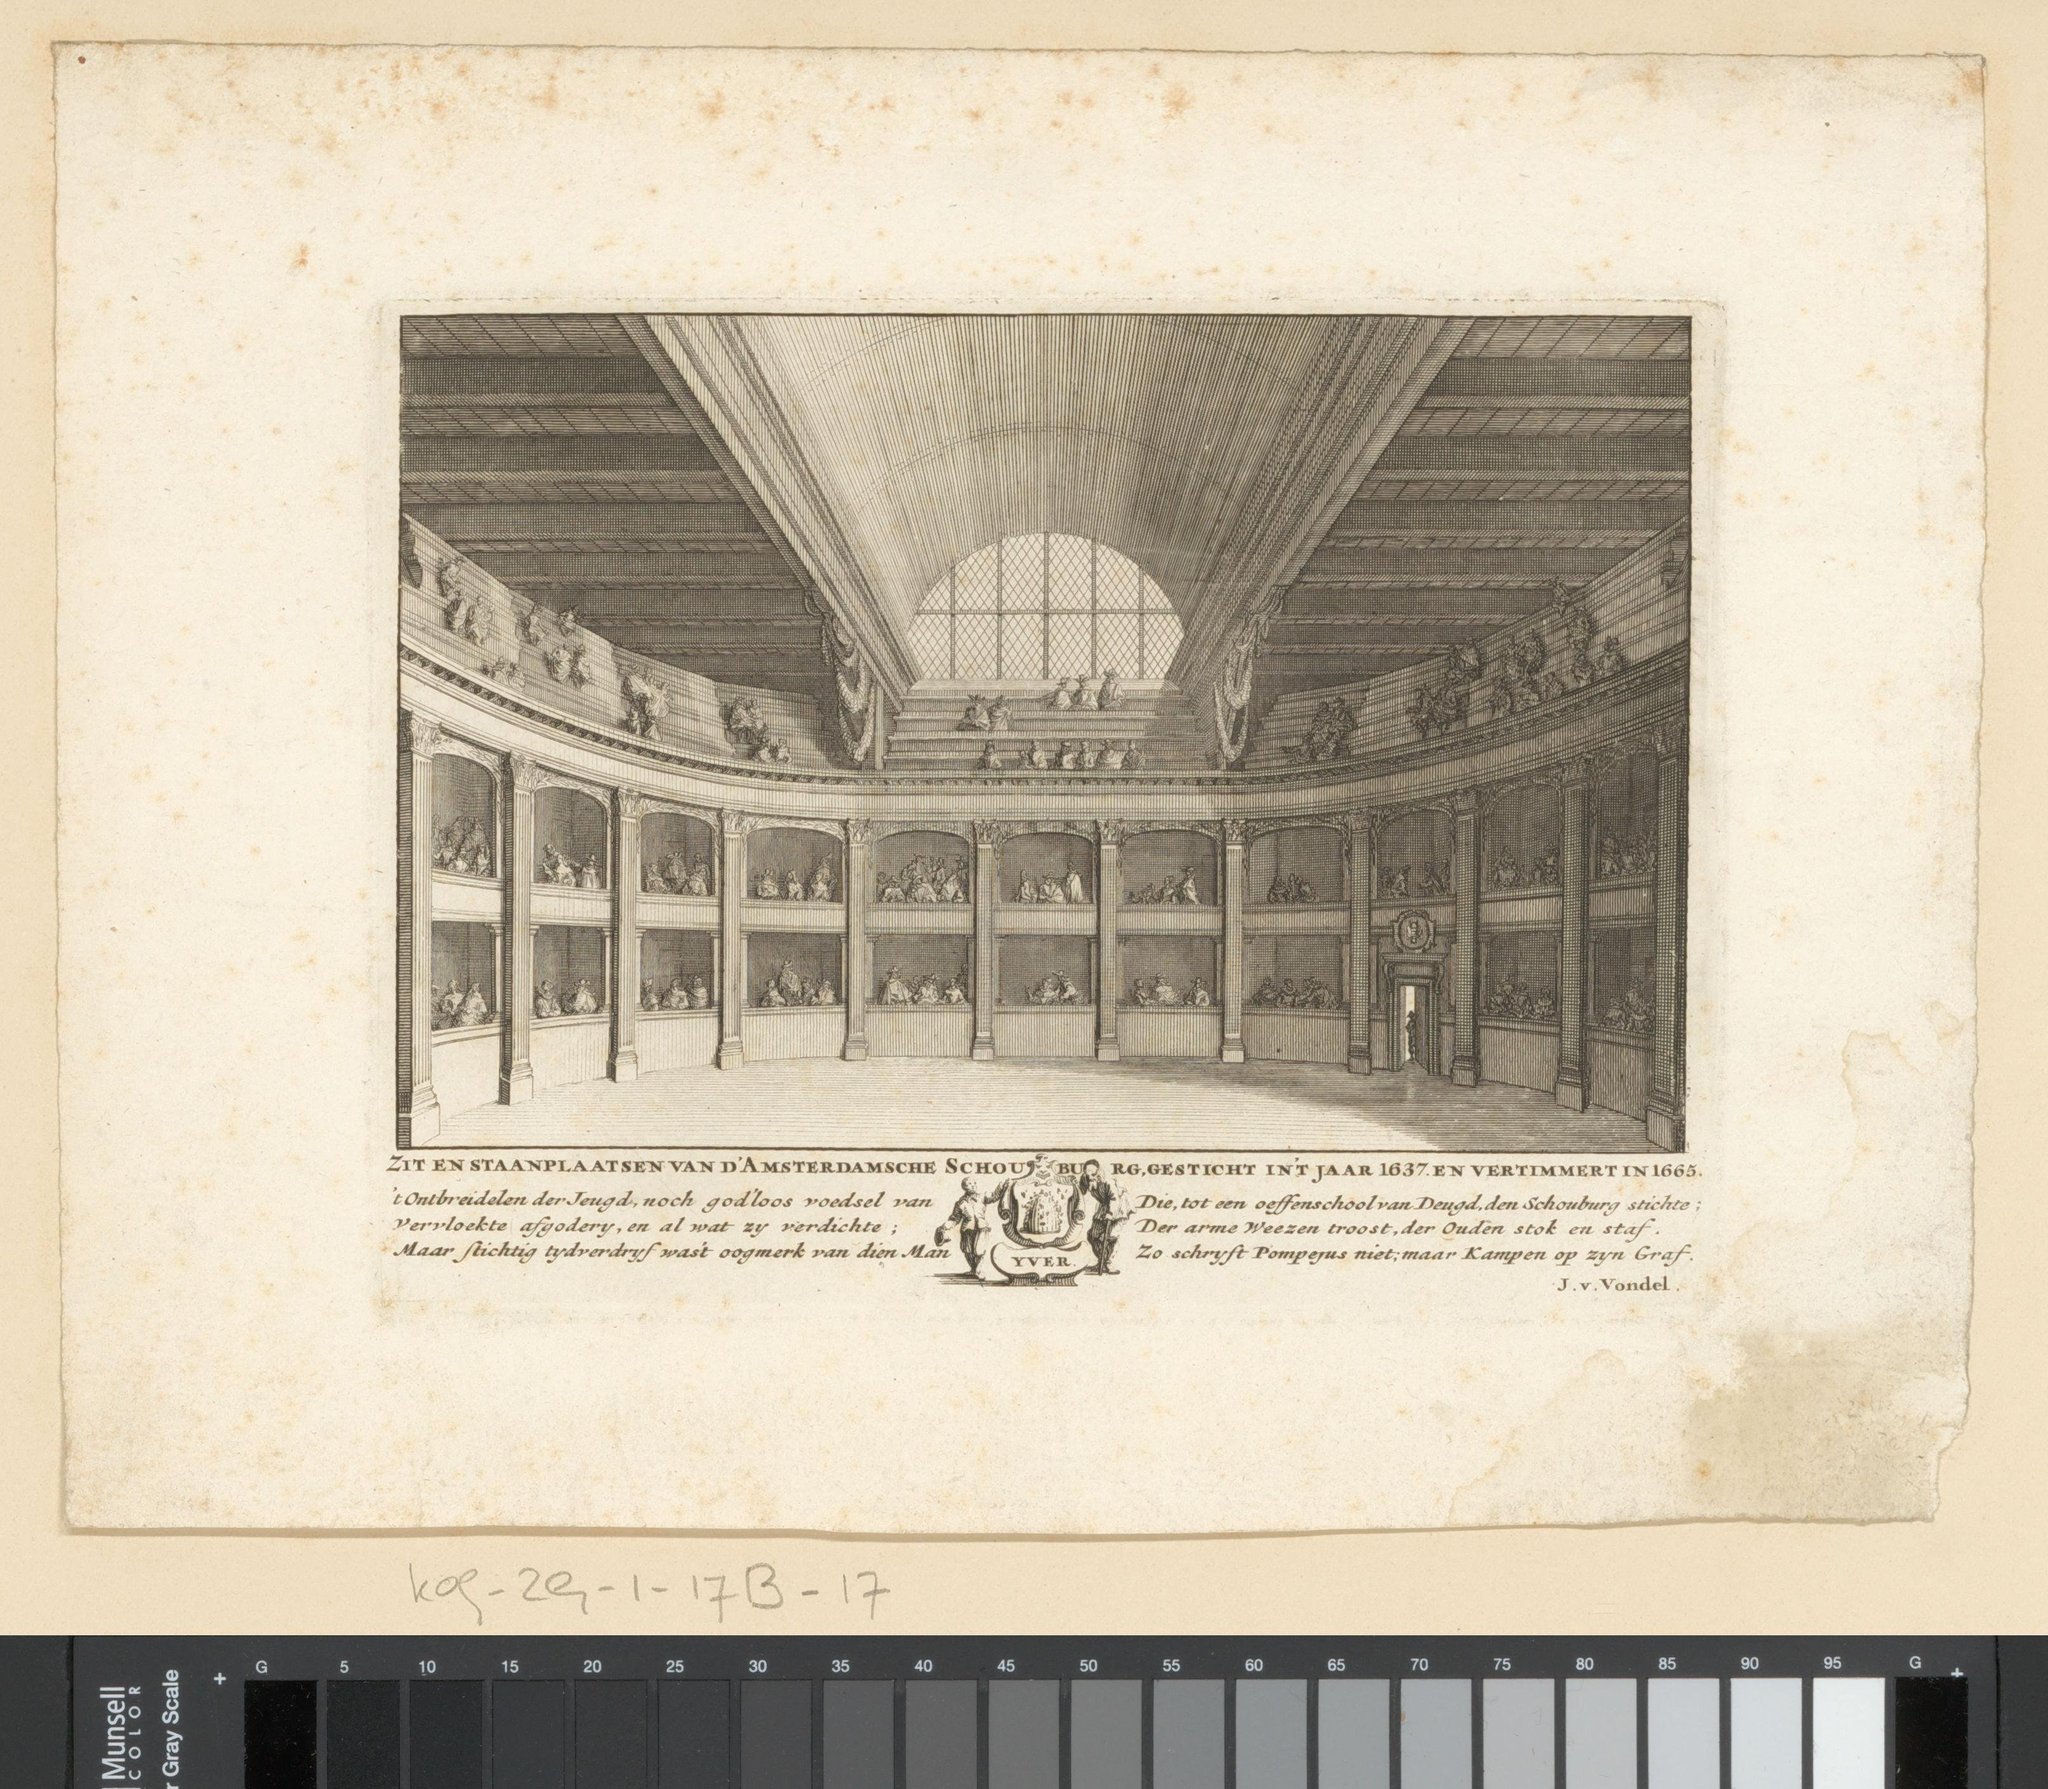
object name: book illustration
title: Zaal van de Amsterdamse Schouwburg aan de Keizersgracht te Amsterdam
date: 1738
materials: paper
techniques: engraving, etching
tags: boxes, loges ~ theatre, etc., theatre (building)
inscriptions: stamp, collector's mark: Lugt 1641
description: Gezicht op de zaal met zit- en staanplaatsen van de Amsterdamse Schouwburg aan de Keizersgracht. Deze stadsschouwburg was ontworpen door Jacob van Campen en was op de plaats van de Nederduitse Academie van Samuel Coster gebouwd (ter hoogte van de huidige Keizersgracht 384). Op 26 december 1637 was de opening. In 1665 werd het gebouw ingrijpend verbouwd en in 1772 brandde het af. In de marge de titel en een zesregelig vers in het Nederlands. Onderwerpsrubrieken binnen de Atlas Zeden en Gewoonten: Schoone kunsten, Tooneel, Schouwburg op de Keizersgracht (1637 – 1772).